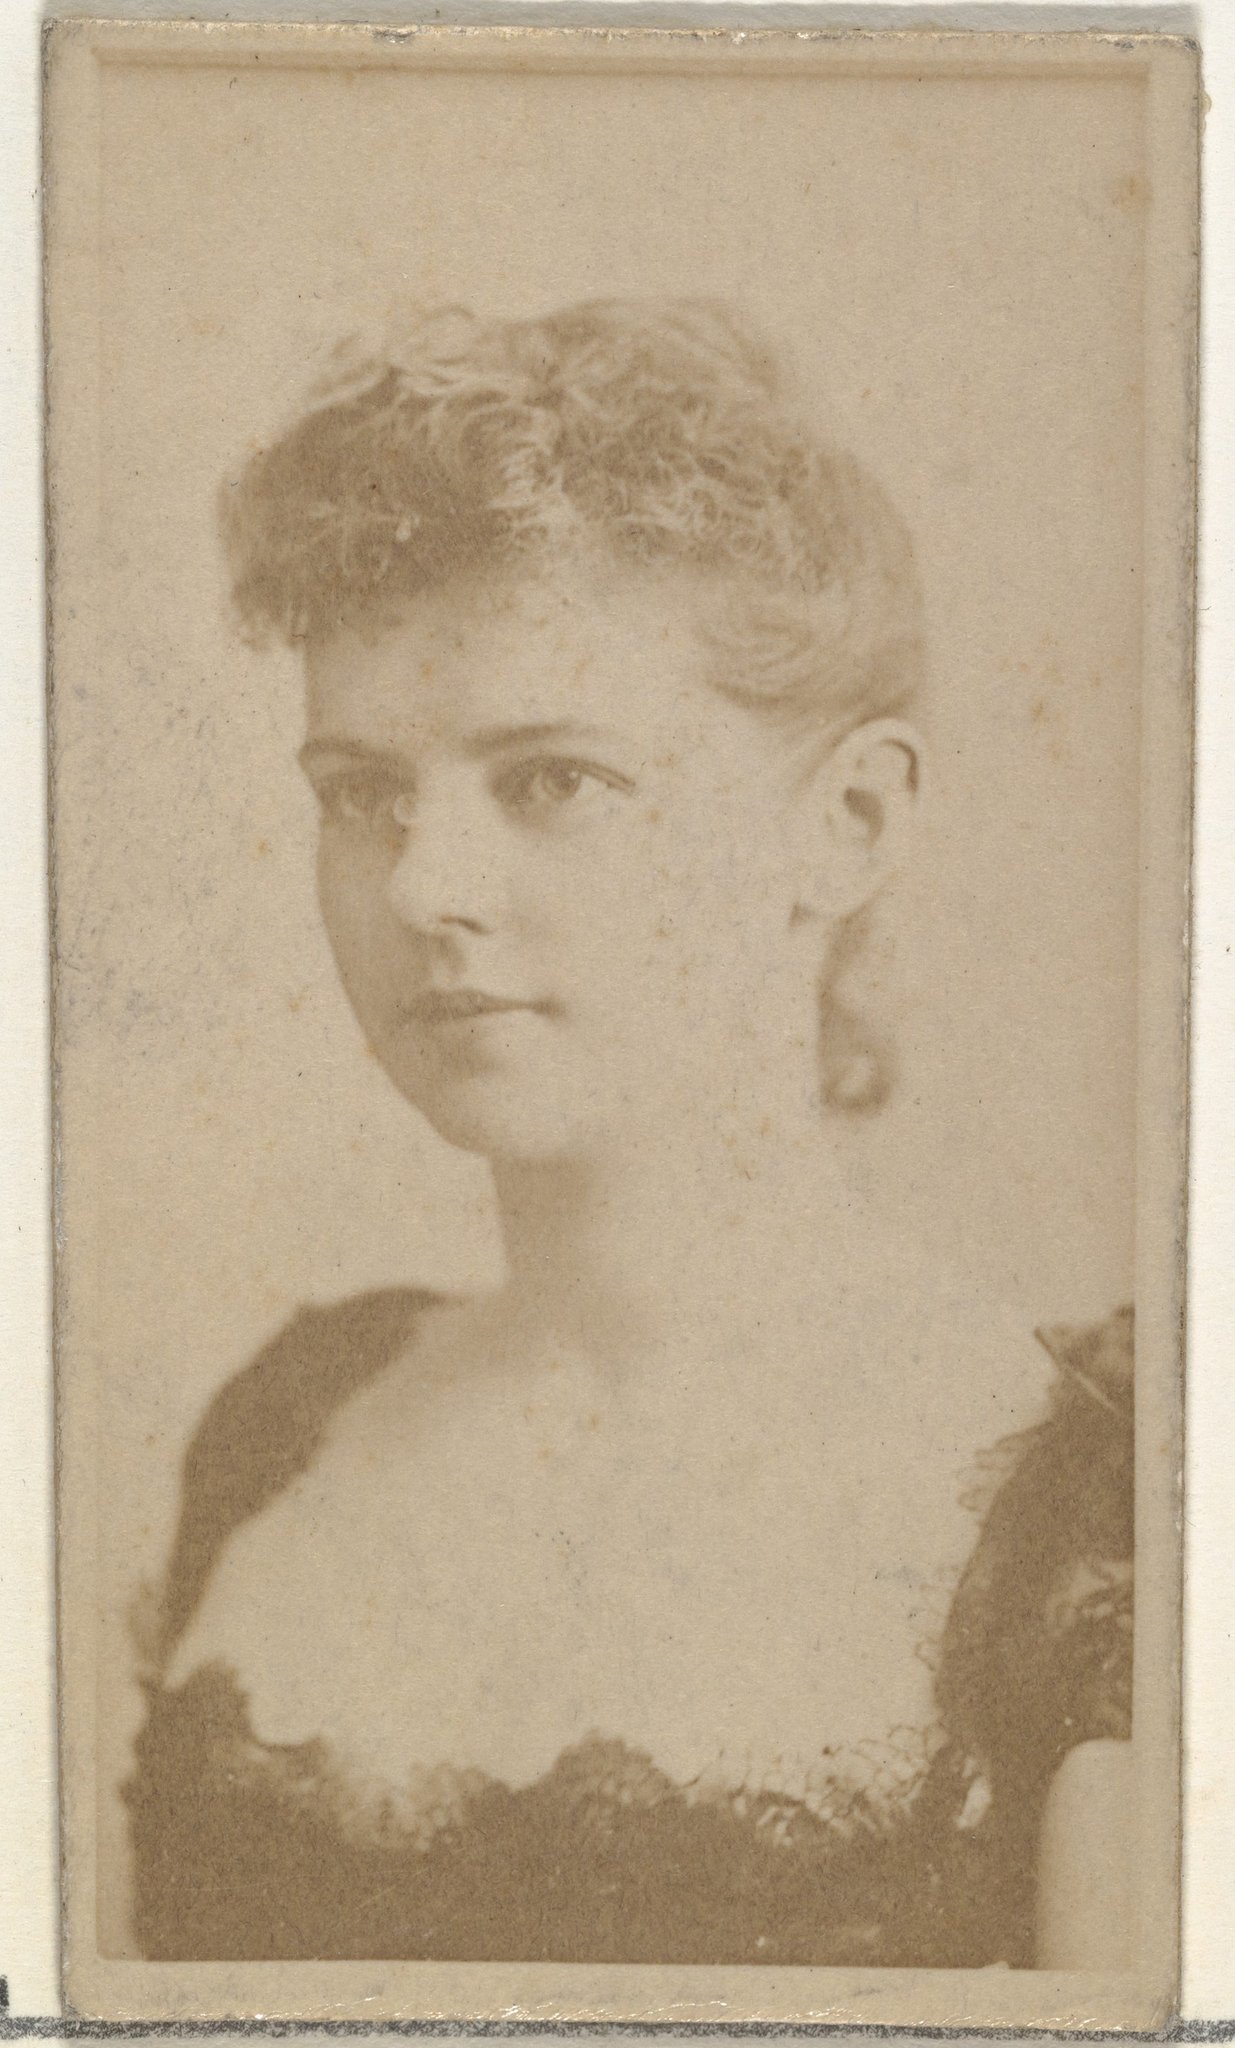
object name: photograph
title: [Actress wearing dark gown with lace neckline], from the Actors and Actresses series (N145-8) issued by Duke Sons & Co. to promote Duke Cigarettes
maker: w. duke, sons & co.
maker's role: publisher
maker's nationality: american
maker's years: 1870-1920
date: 1891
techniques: albumen silver print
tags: portraits,women,actresses